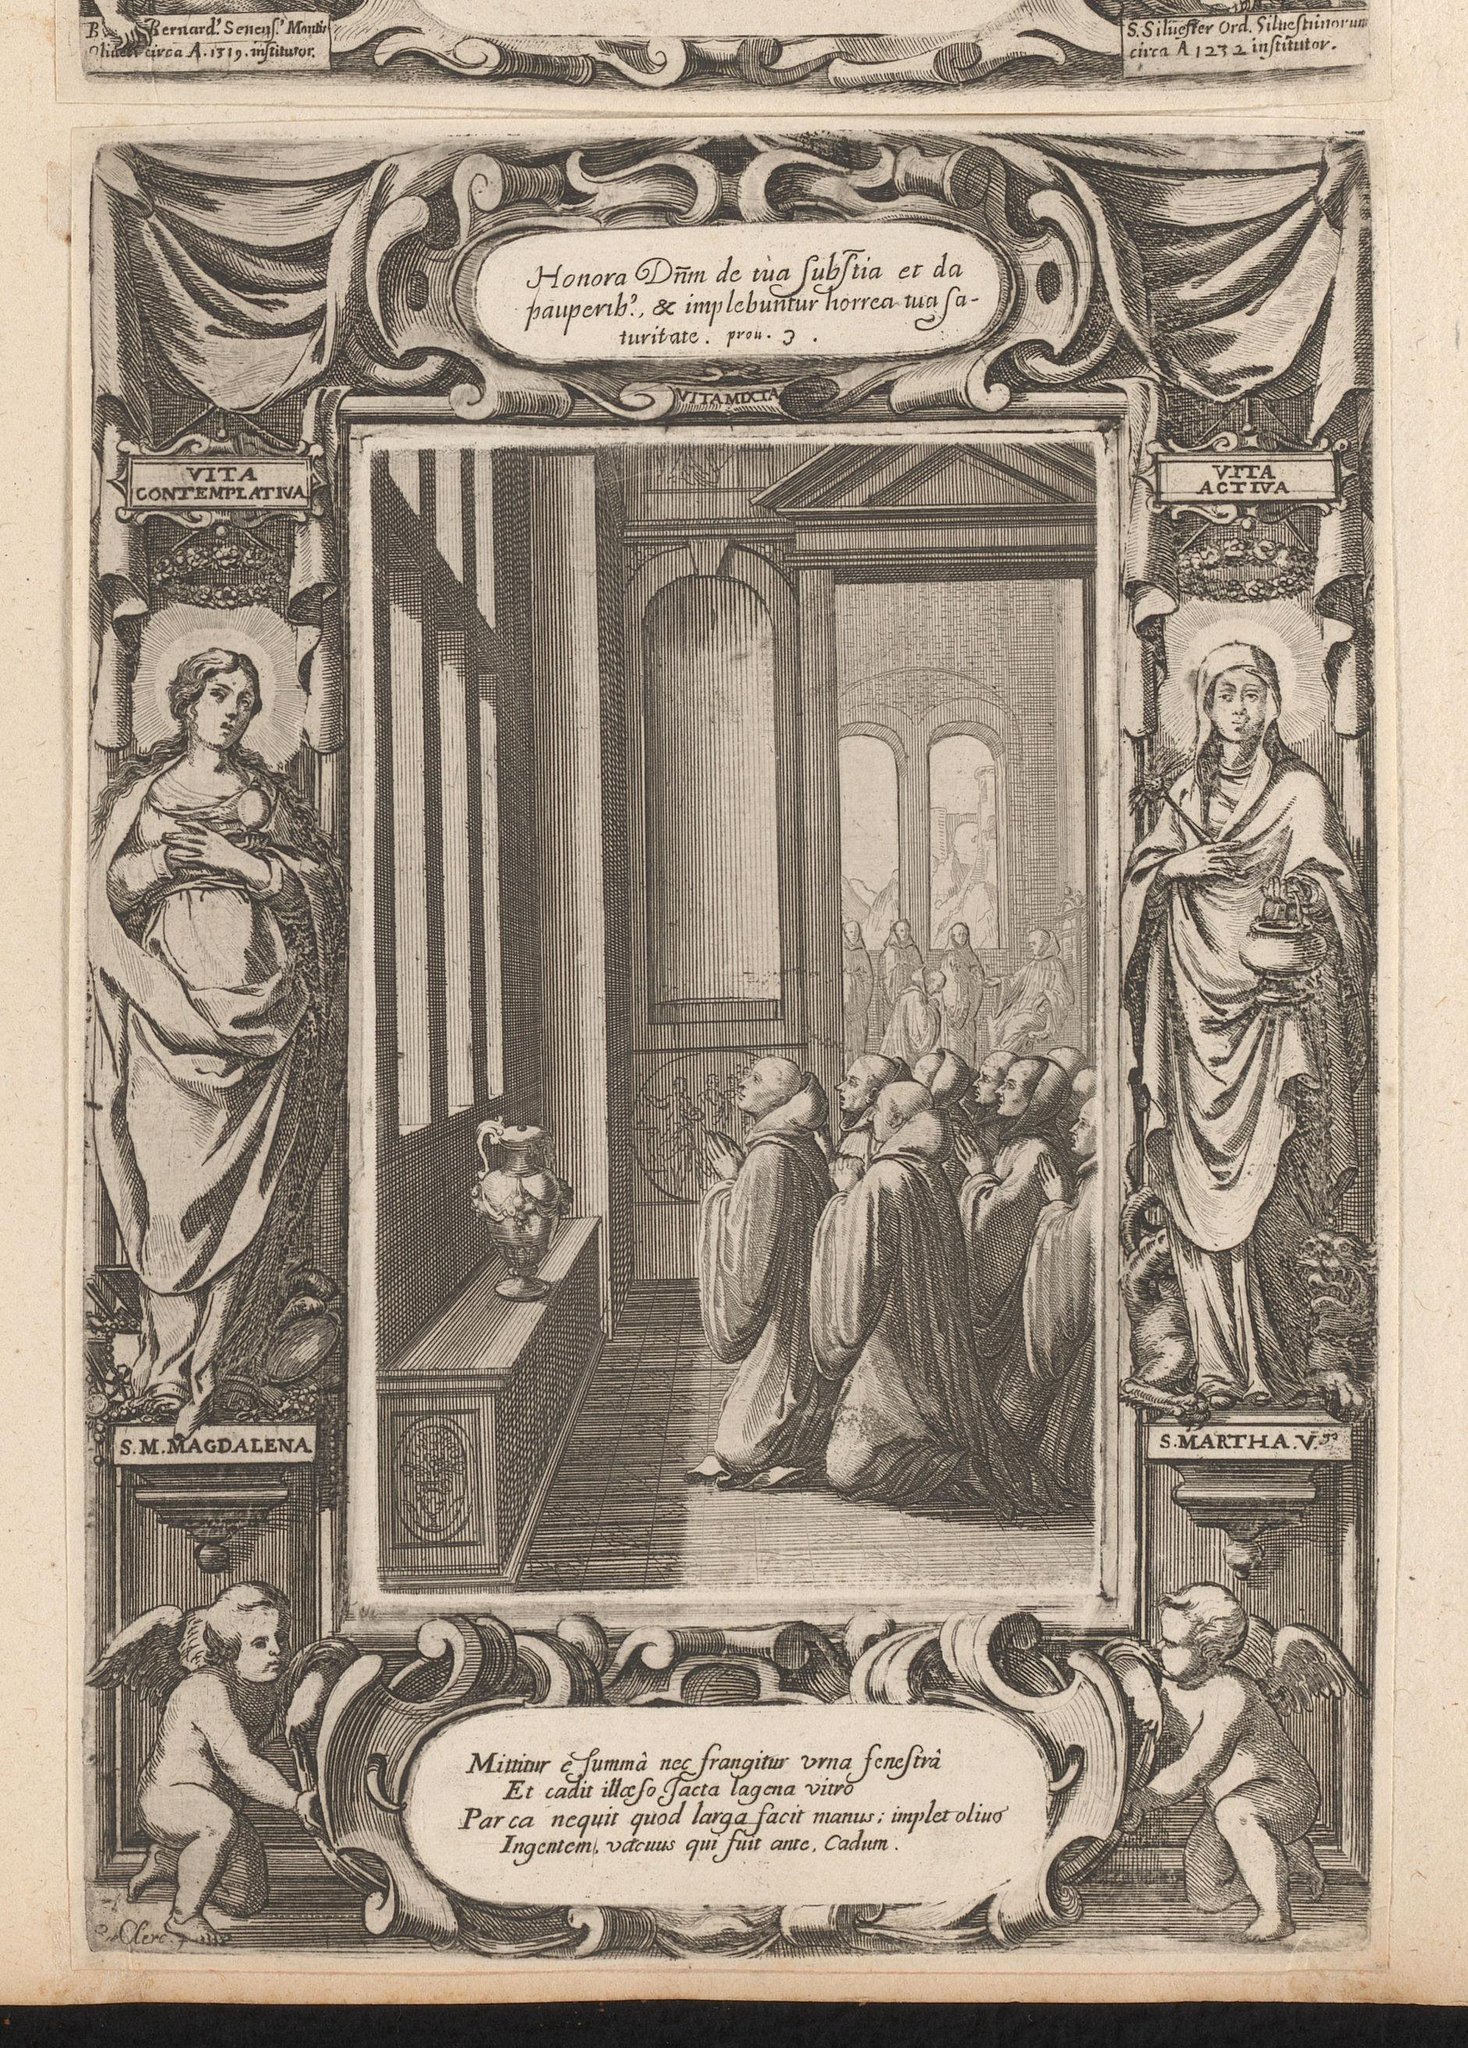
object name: album leaf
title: Vita et Miracula Sanctissimi Patris Benedecti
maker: sébastien leclerc (i)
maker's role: print maker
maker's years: 1637-1714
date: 1658-1659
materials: paper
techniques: etching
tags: benedict of nurcia, abbot of monte cassino and founder of the benedictine order; possible attributes: aspergillum, book, cup (sometimes broken), raven with loaf, sieve (or tray), monastic orders, monastic life: benedictines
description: Maakt deel uit van een serie bestaande uit 33 prenten met voorstellingen uit het leven van de Heilige Benedictus van Nursia in ornamentele cartouches, uitgegeven in 1658-1659. De prenten zijn gedrukt van drie afzonderlijke platen bestaande uit de voorstelling, de cartouche en de tekst.